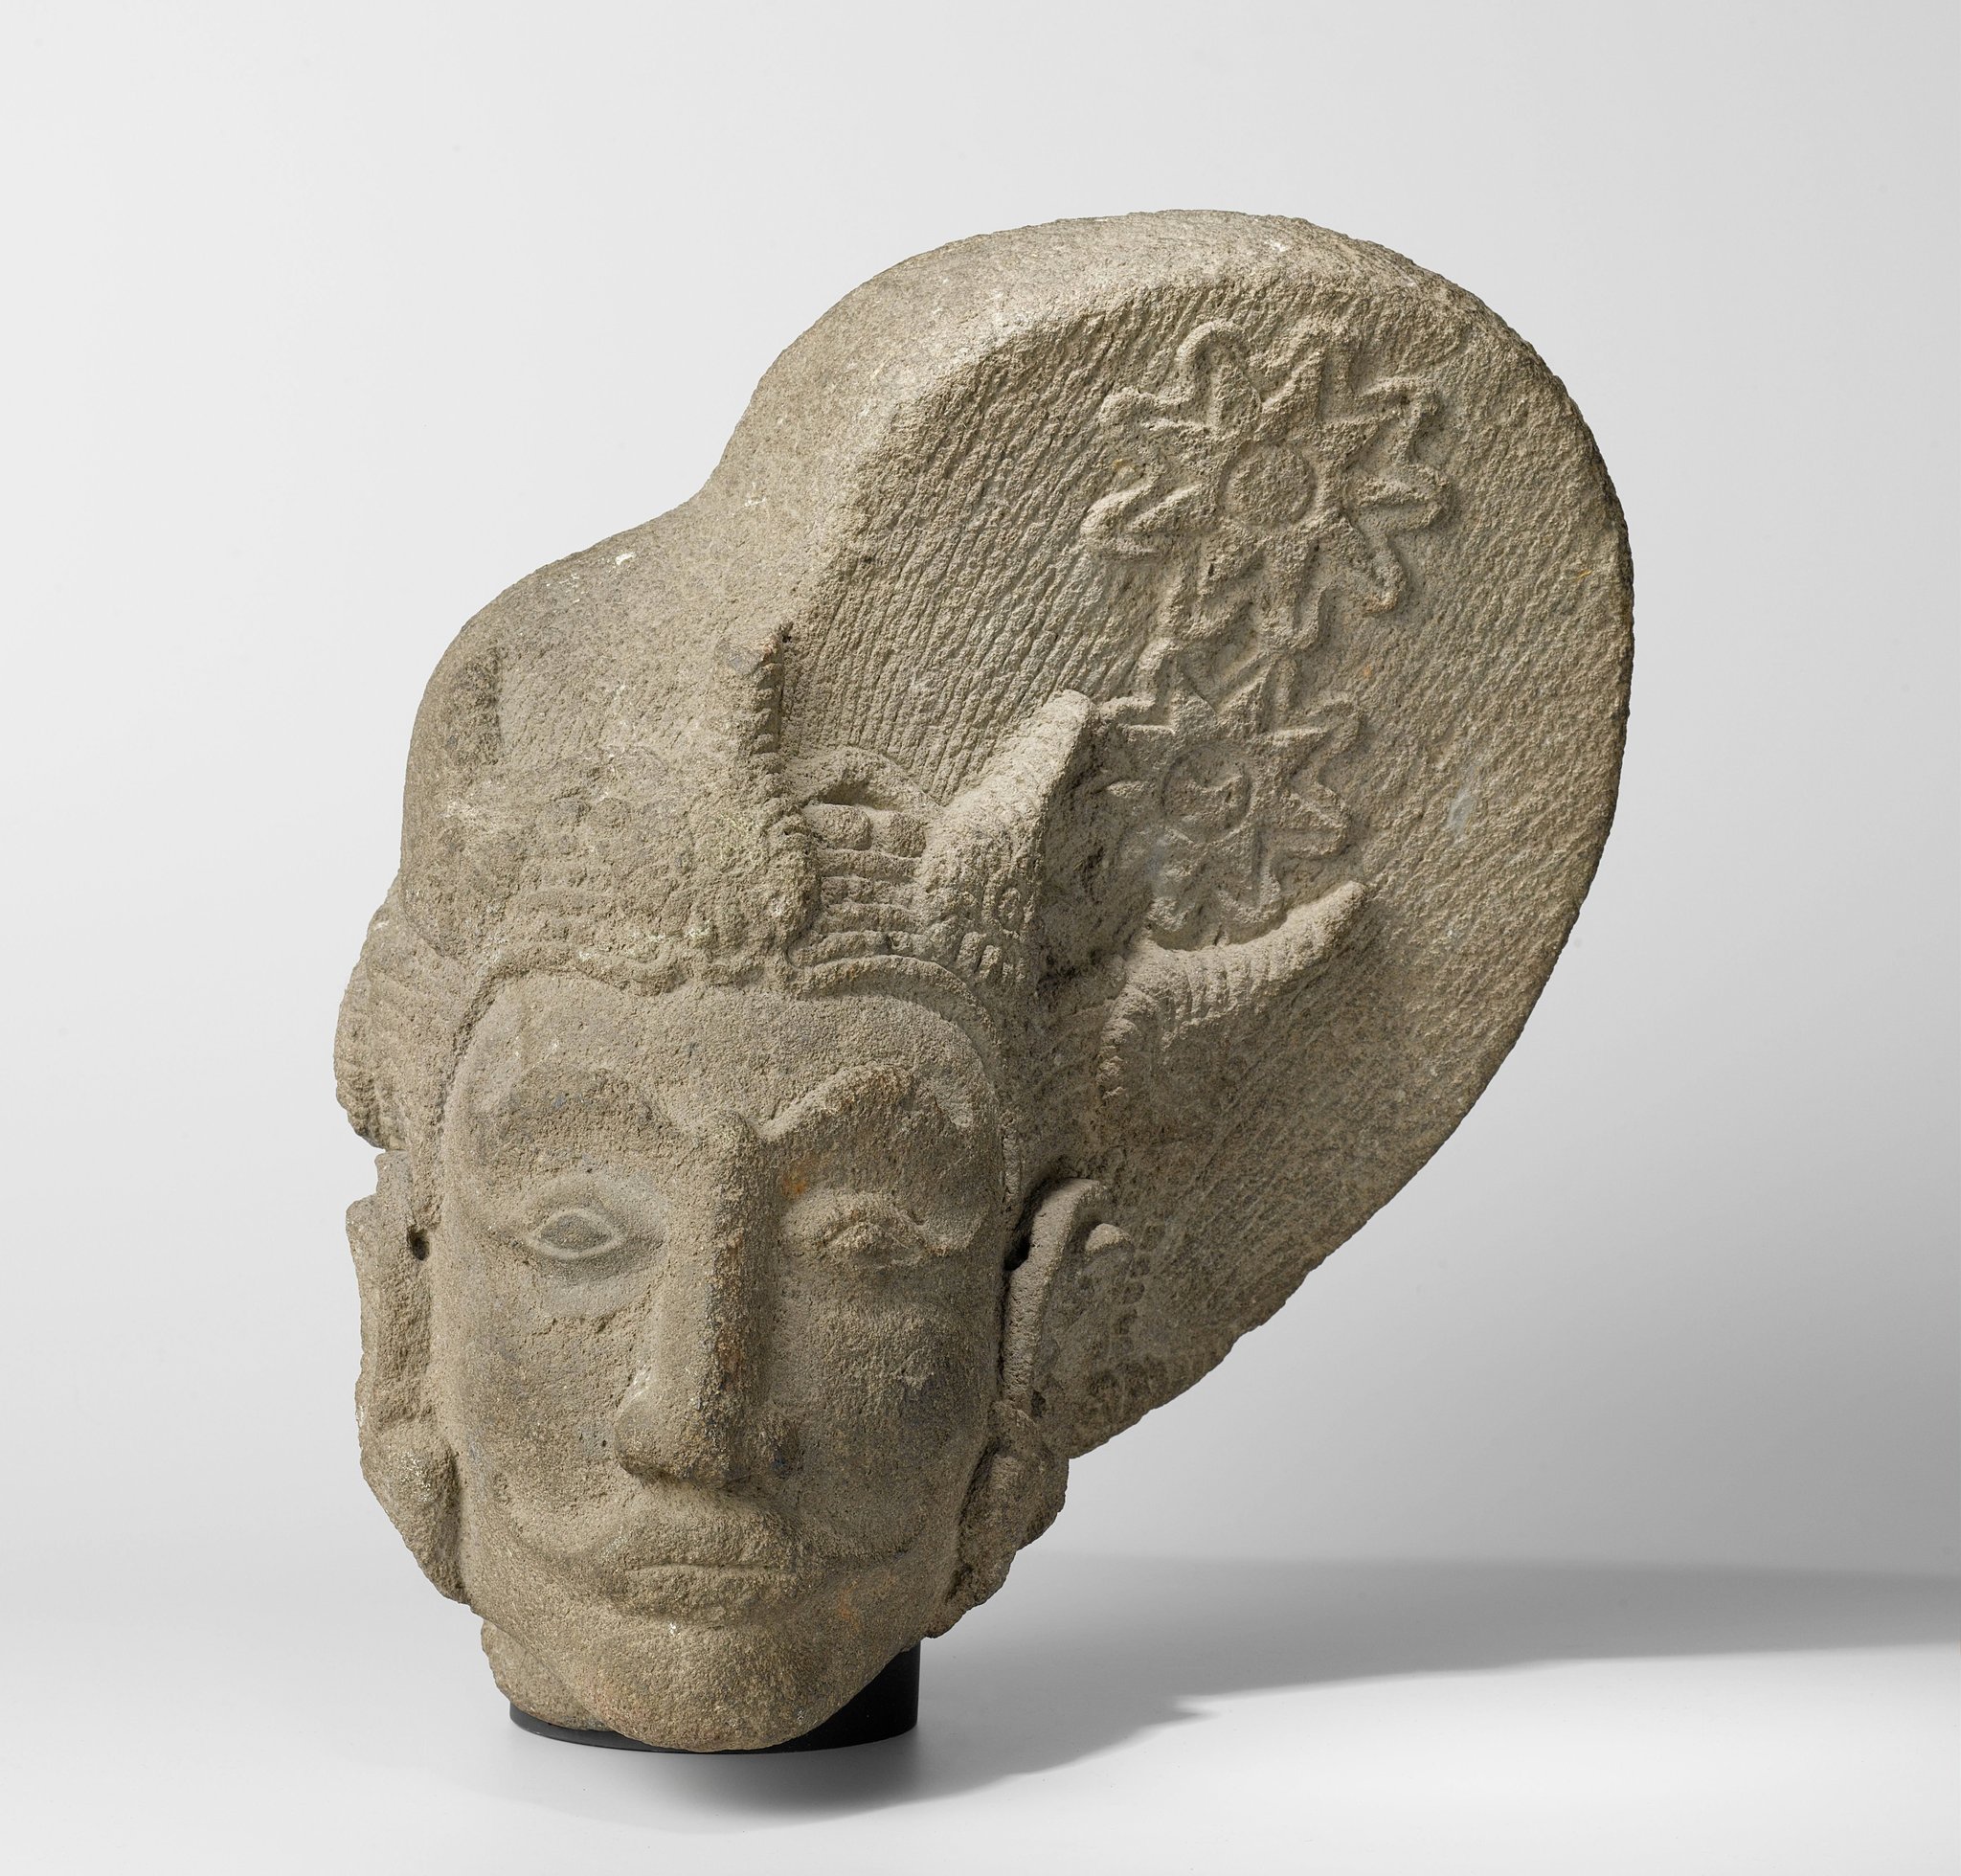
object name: hoofd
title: Head of an Unknown Male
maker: Anonymous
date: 1425-1475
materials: stone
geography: java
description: This mysterious head probably comes from either Candi Sukuh or Candi Cetoh – two temples located high in the mountains between Central and East Java. The asymmetrical headgear is decorated with flowers or stars, while the face has the features of a warrior. The identity of the male figure is unknown; he may have played a role in a warrior cult or perhaps was associated with astrology